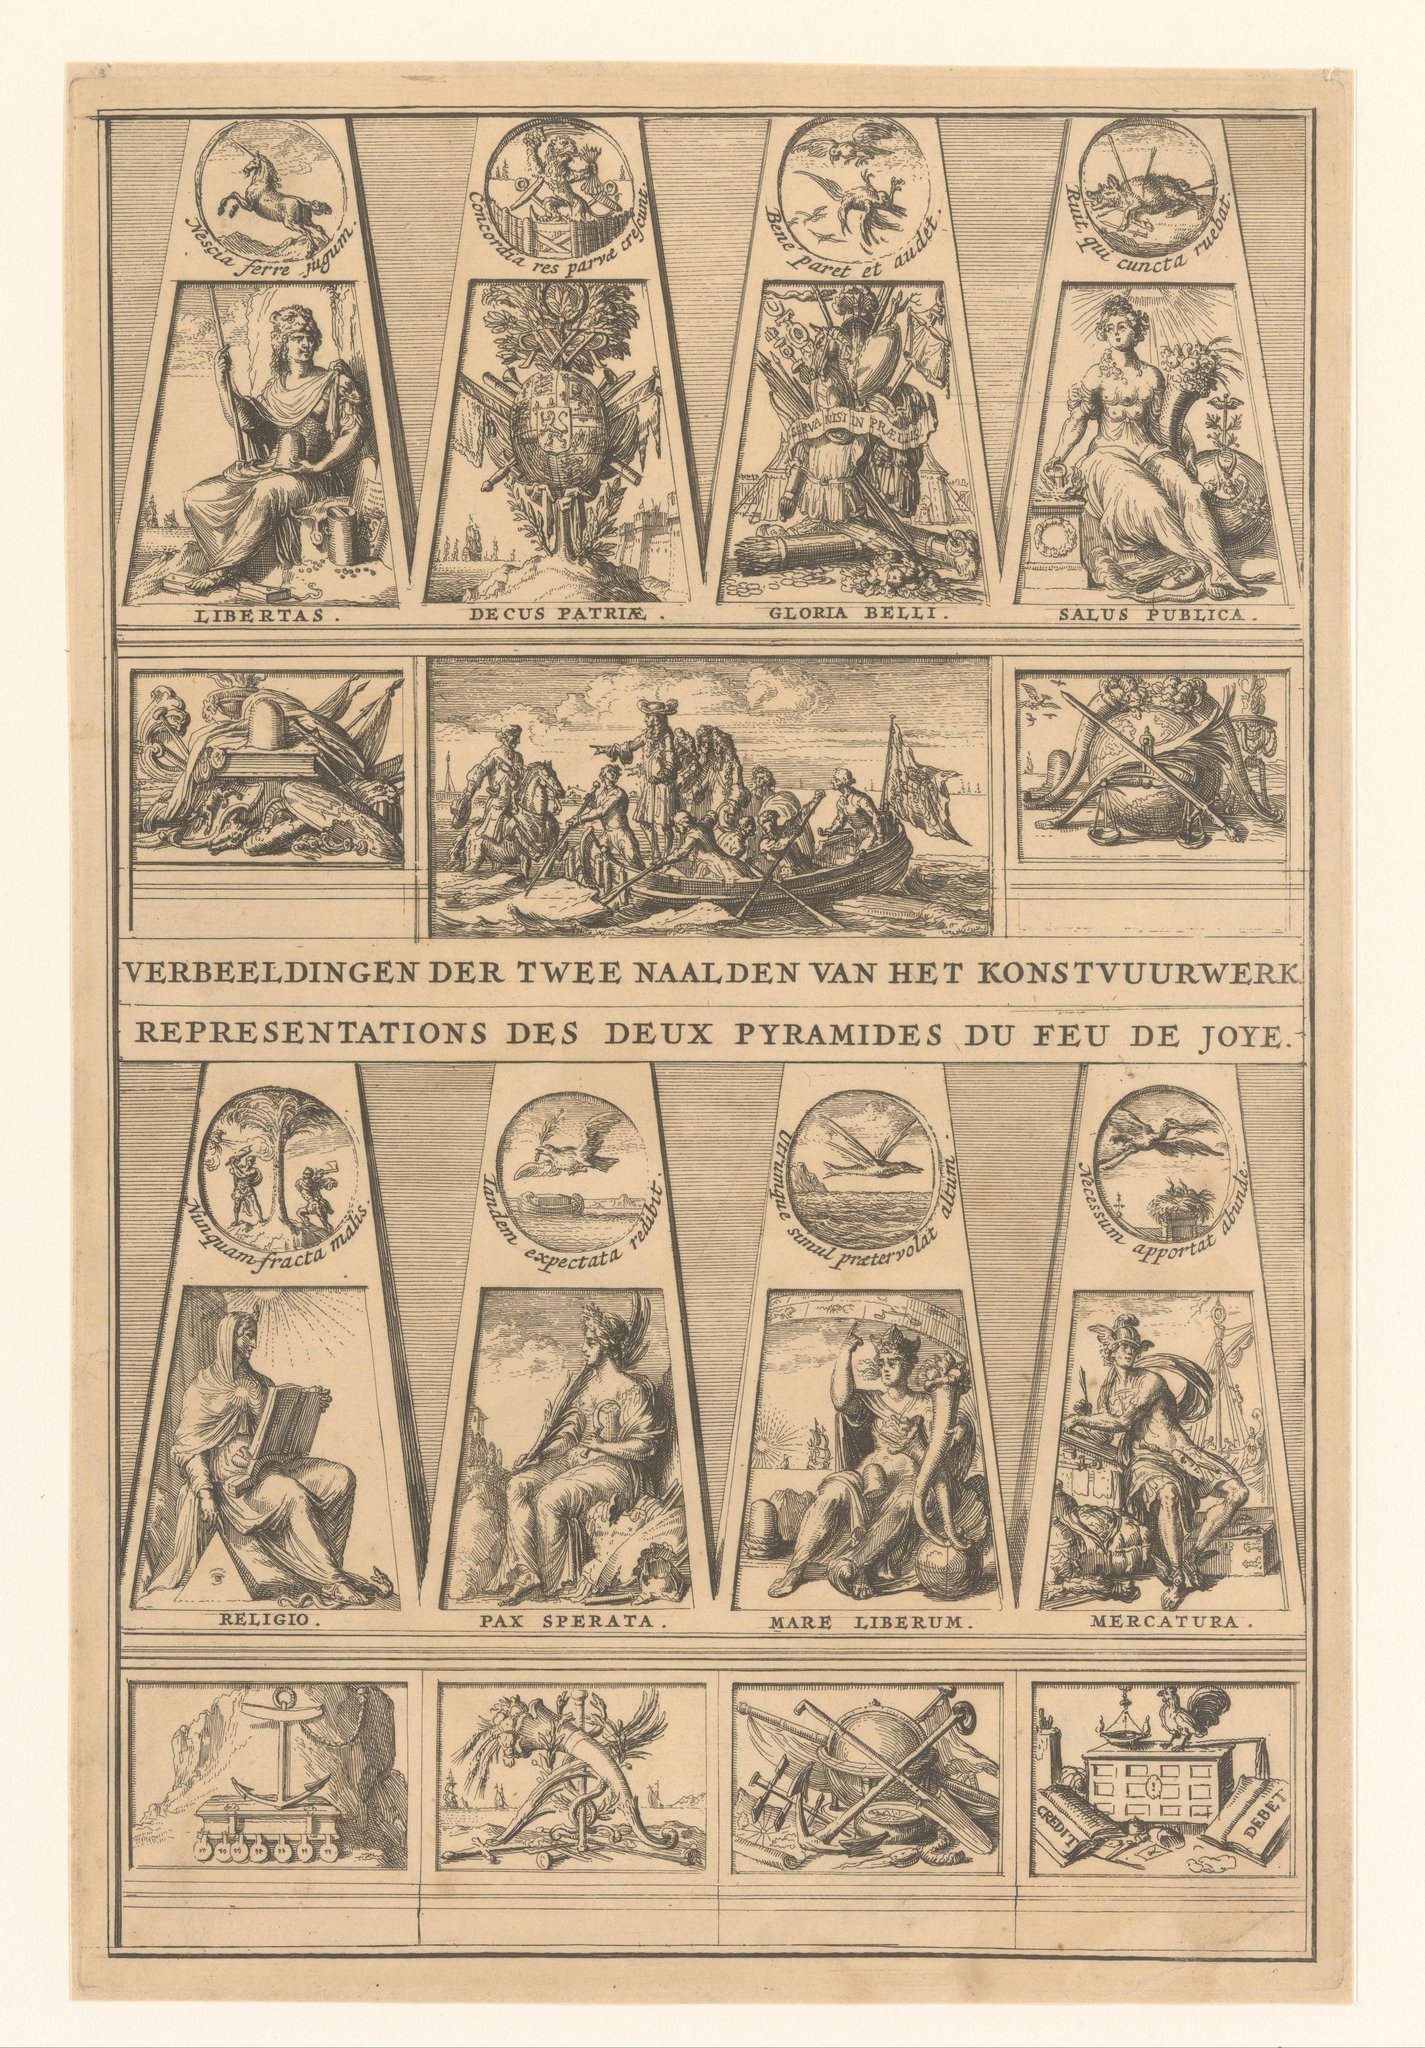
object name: print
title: Verbeeldingen der twee naalden van het konstvuurwerk / Representations des deux Pyramides du feu de joye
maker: romeyn de hooghe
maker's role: draughtsman, goldsmith, painter, print maker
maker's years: 1645-1708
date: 1691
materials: paper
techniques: etching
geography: northern netherlands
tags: the hague, william iii (prince of orange and king of england, scotland, and ireland), coat of arms (as symbol of the state, etc.), sea personified; 'mare' (ripa), triumphal entry and public reception, pageant, 'entrée solennelle', 'joyeuse entrée', libertas as roman personification, historical persons, welfare, prosperity; 'felicità publica', 'prosperità della vita', 'salute' (ripa), merchant shipping, shipping trade, pax as roman personification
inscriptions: collector's mark: Lugt 2228, collector's mark: Lugt 2760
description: Overzicht van de verschillende allegorische voorstellingen aangebracht op de vuurwerkstellages in de Hofvijver, ter gelegenheid van de intocht van stadhouder-koning Willem III te Den Haag, 5 februari 1691. Midden boven de aankomst van de roeiboot met de koning bij Oranjepolder op 31 januari 1691. Rondom zijn acht personificaties afgebeeld.